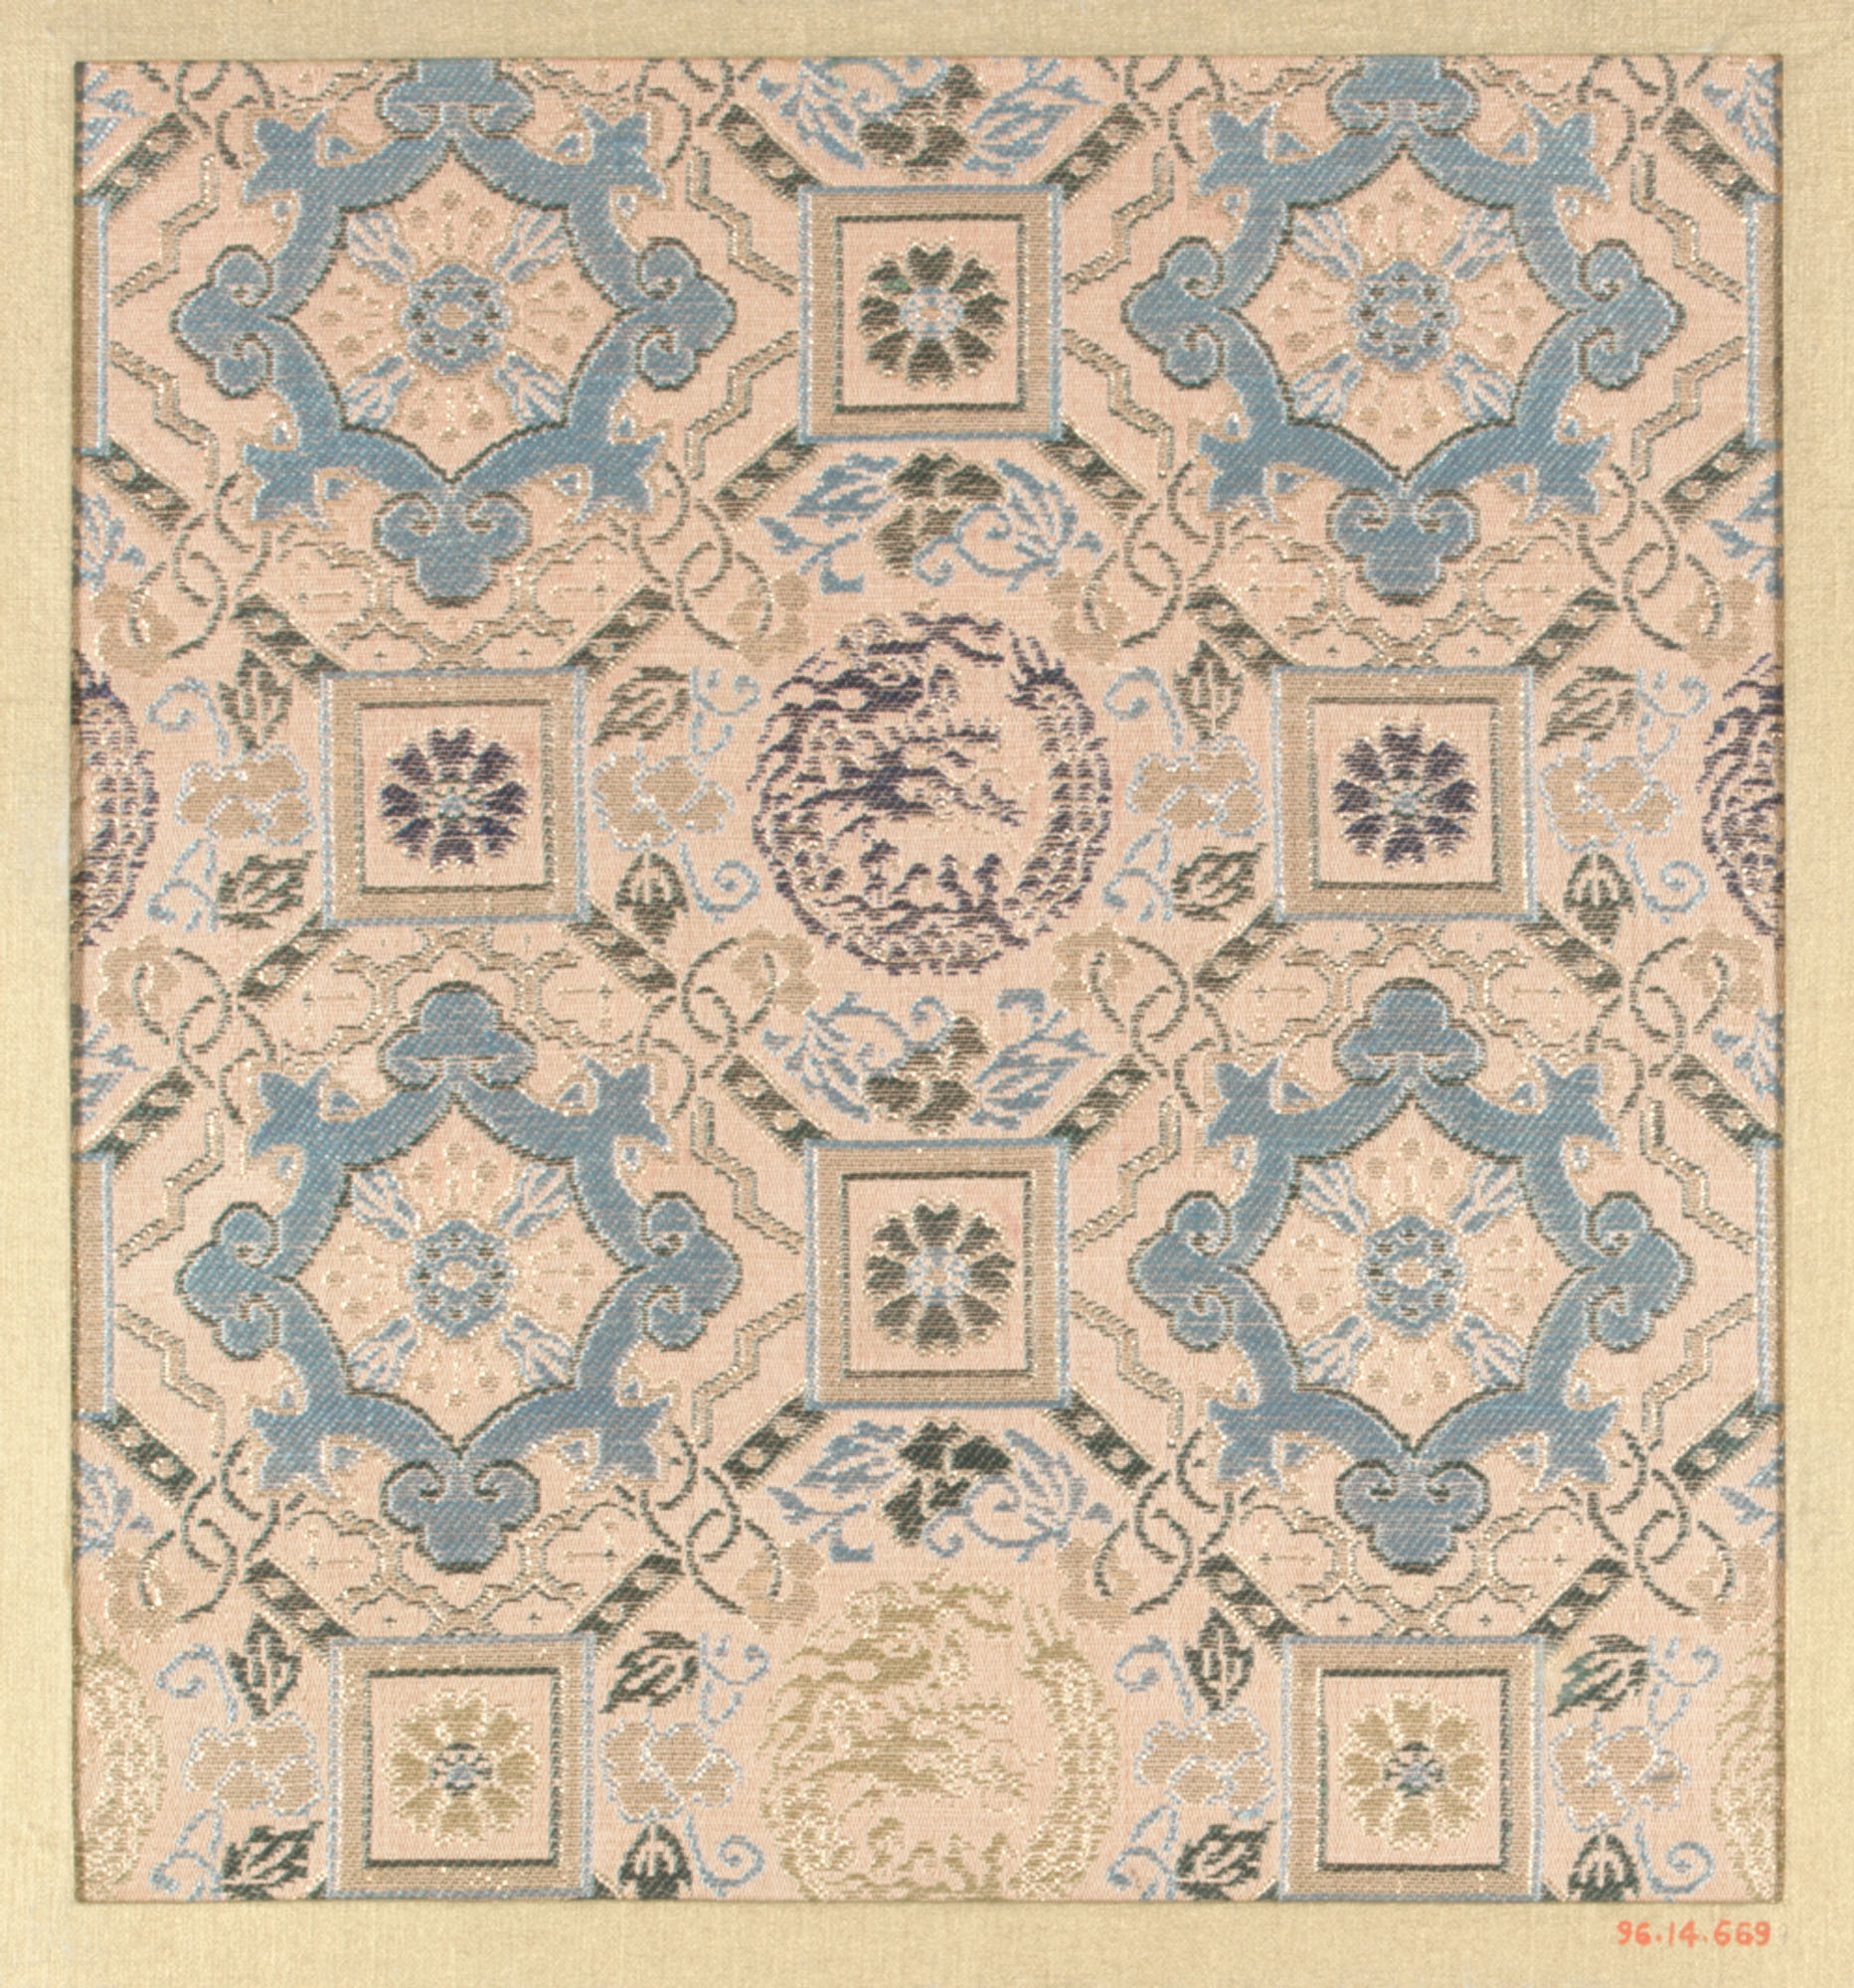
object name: piece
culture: japanese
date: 1701-1900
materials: silk